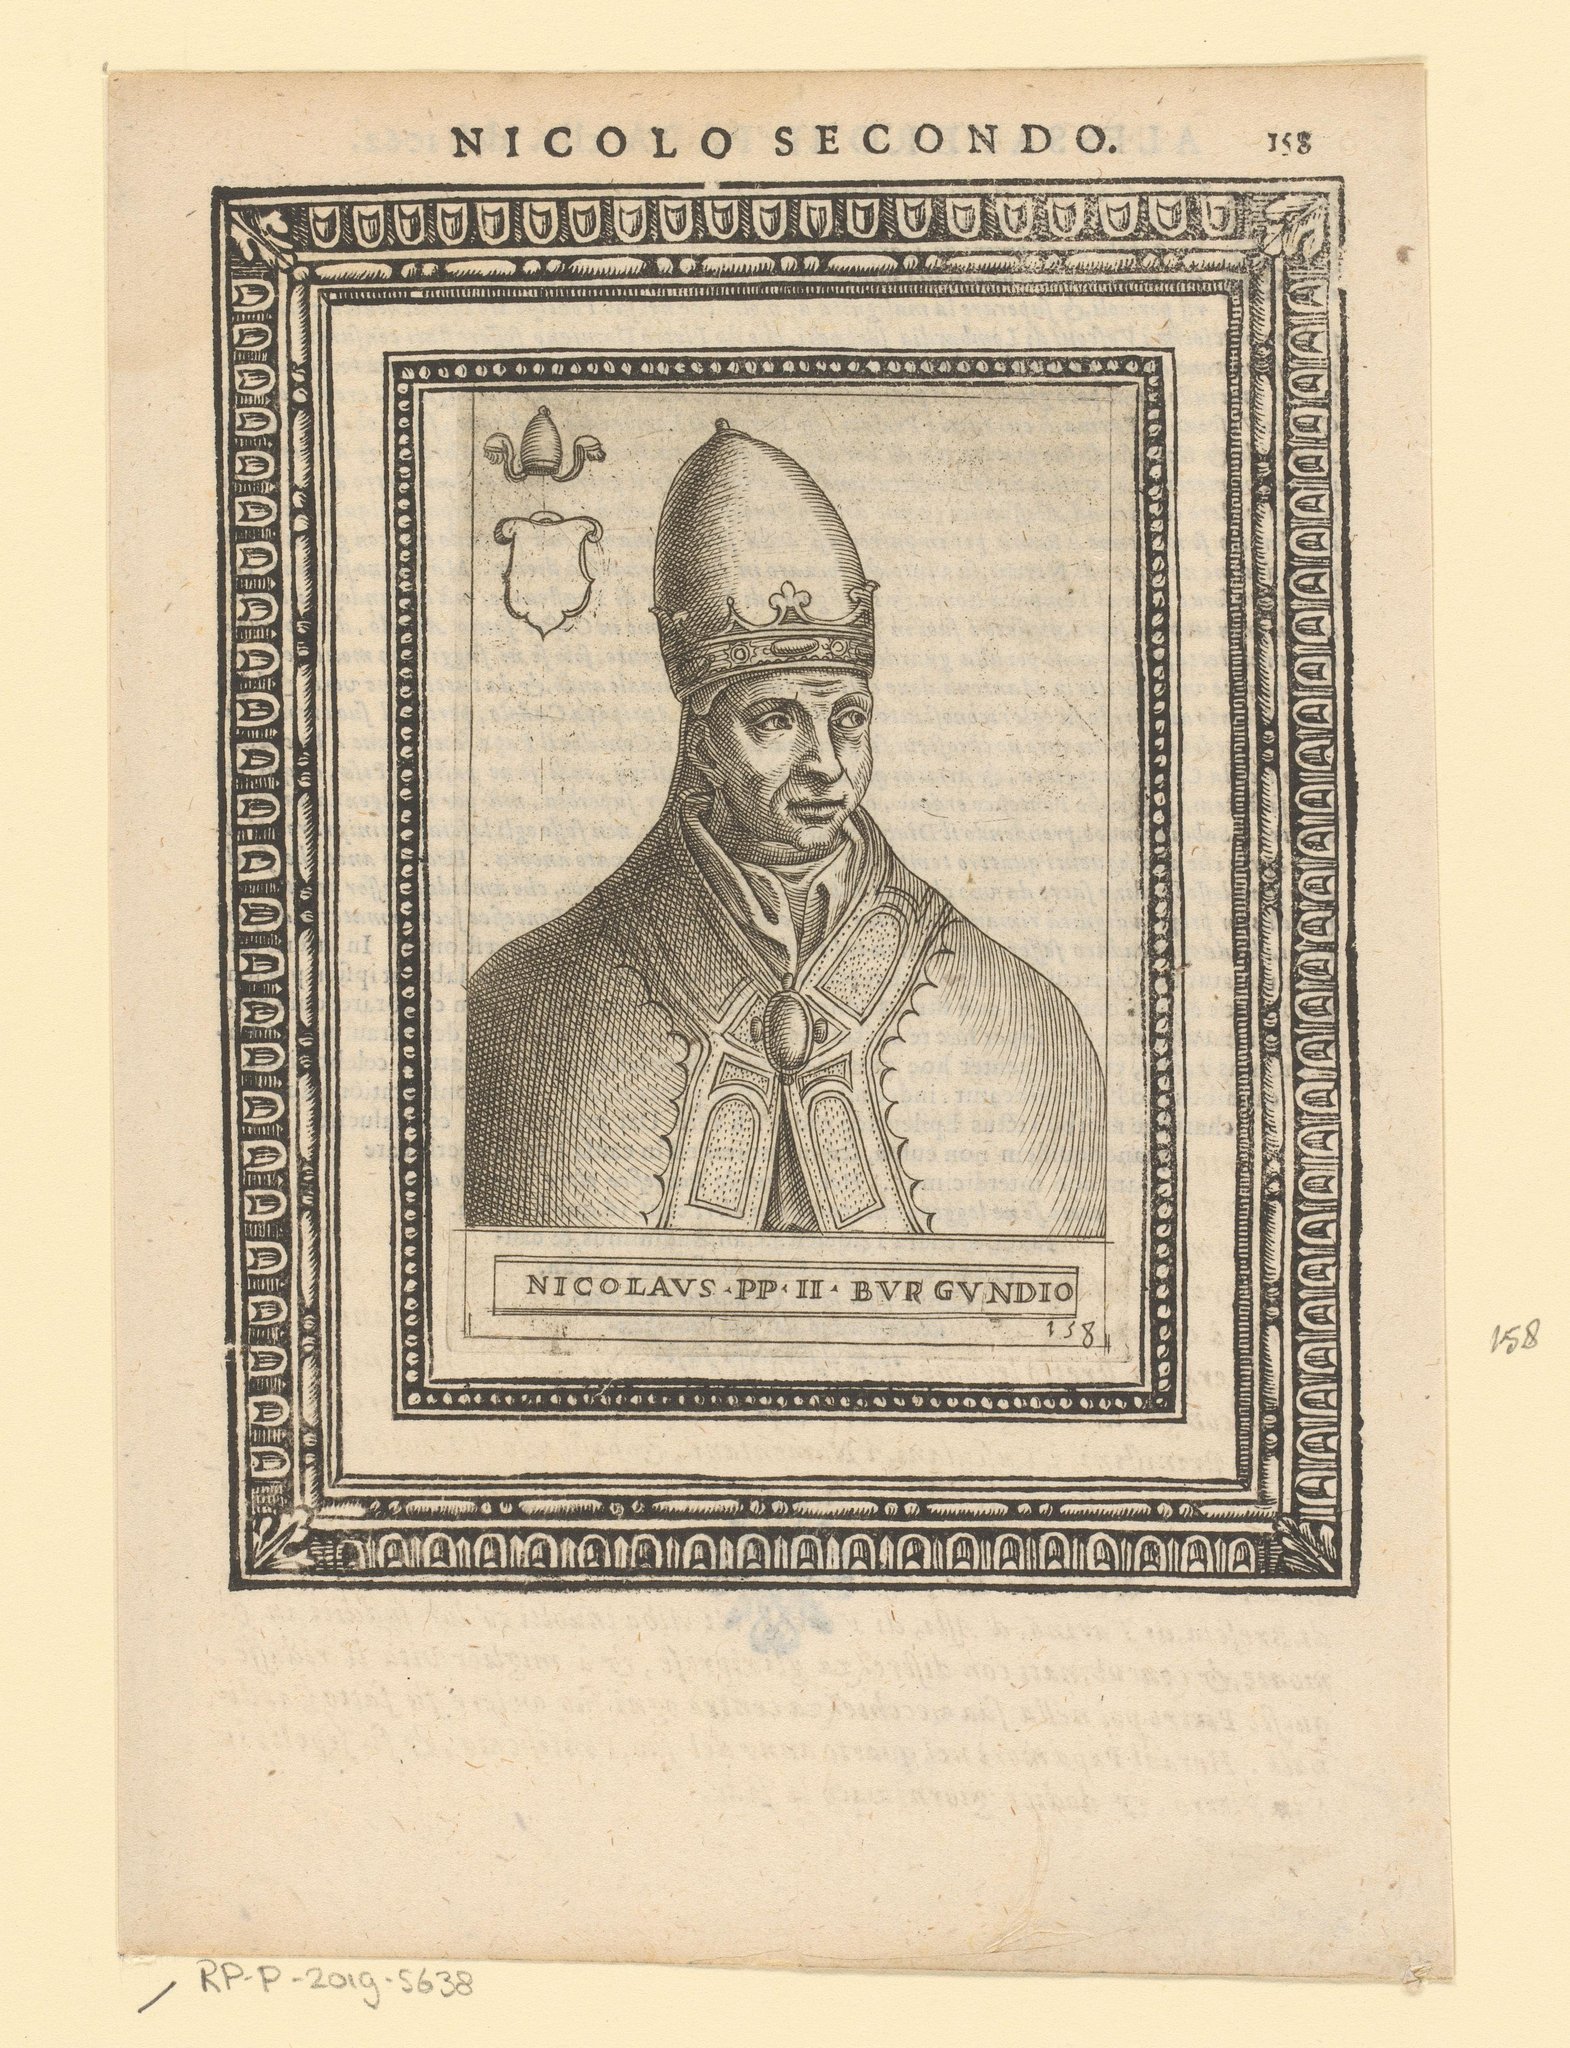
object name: print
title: Portret van paus Nicolaas II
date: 1587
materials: paper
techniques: engraving, letterpress printing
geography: rome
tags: historical persons, pope, armorial bearing, heraldry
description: Prent uit: Ciccarelli, Antonio. Le vite de Pontefici di Antonio Ciccarelli (...). Rome: Domenico Basa, 1587. Prent voor het eerst verschenen in: Cavalieri, Giovanni Battista de'. Pontificum romanorum effigies (...). Rome: Domenico Basa en Francesco Zanetti, 1580. Prent ook gebruikt in latere publicaties.